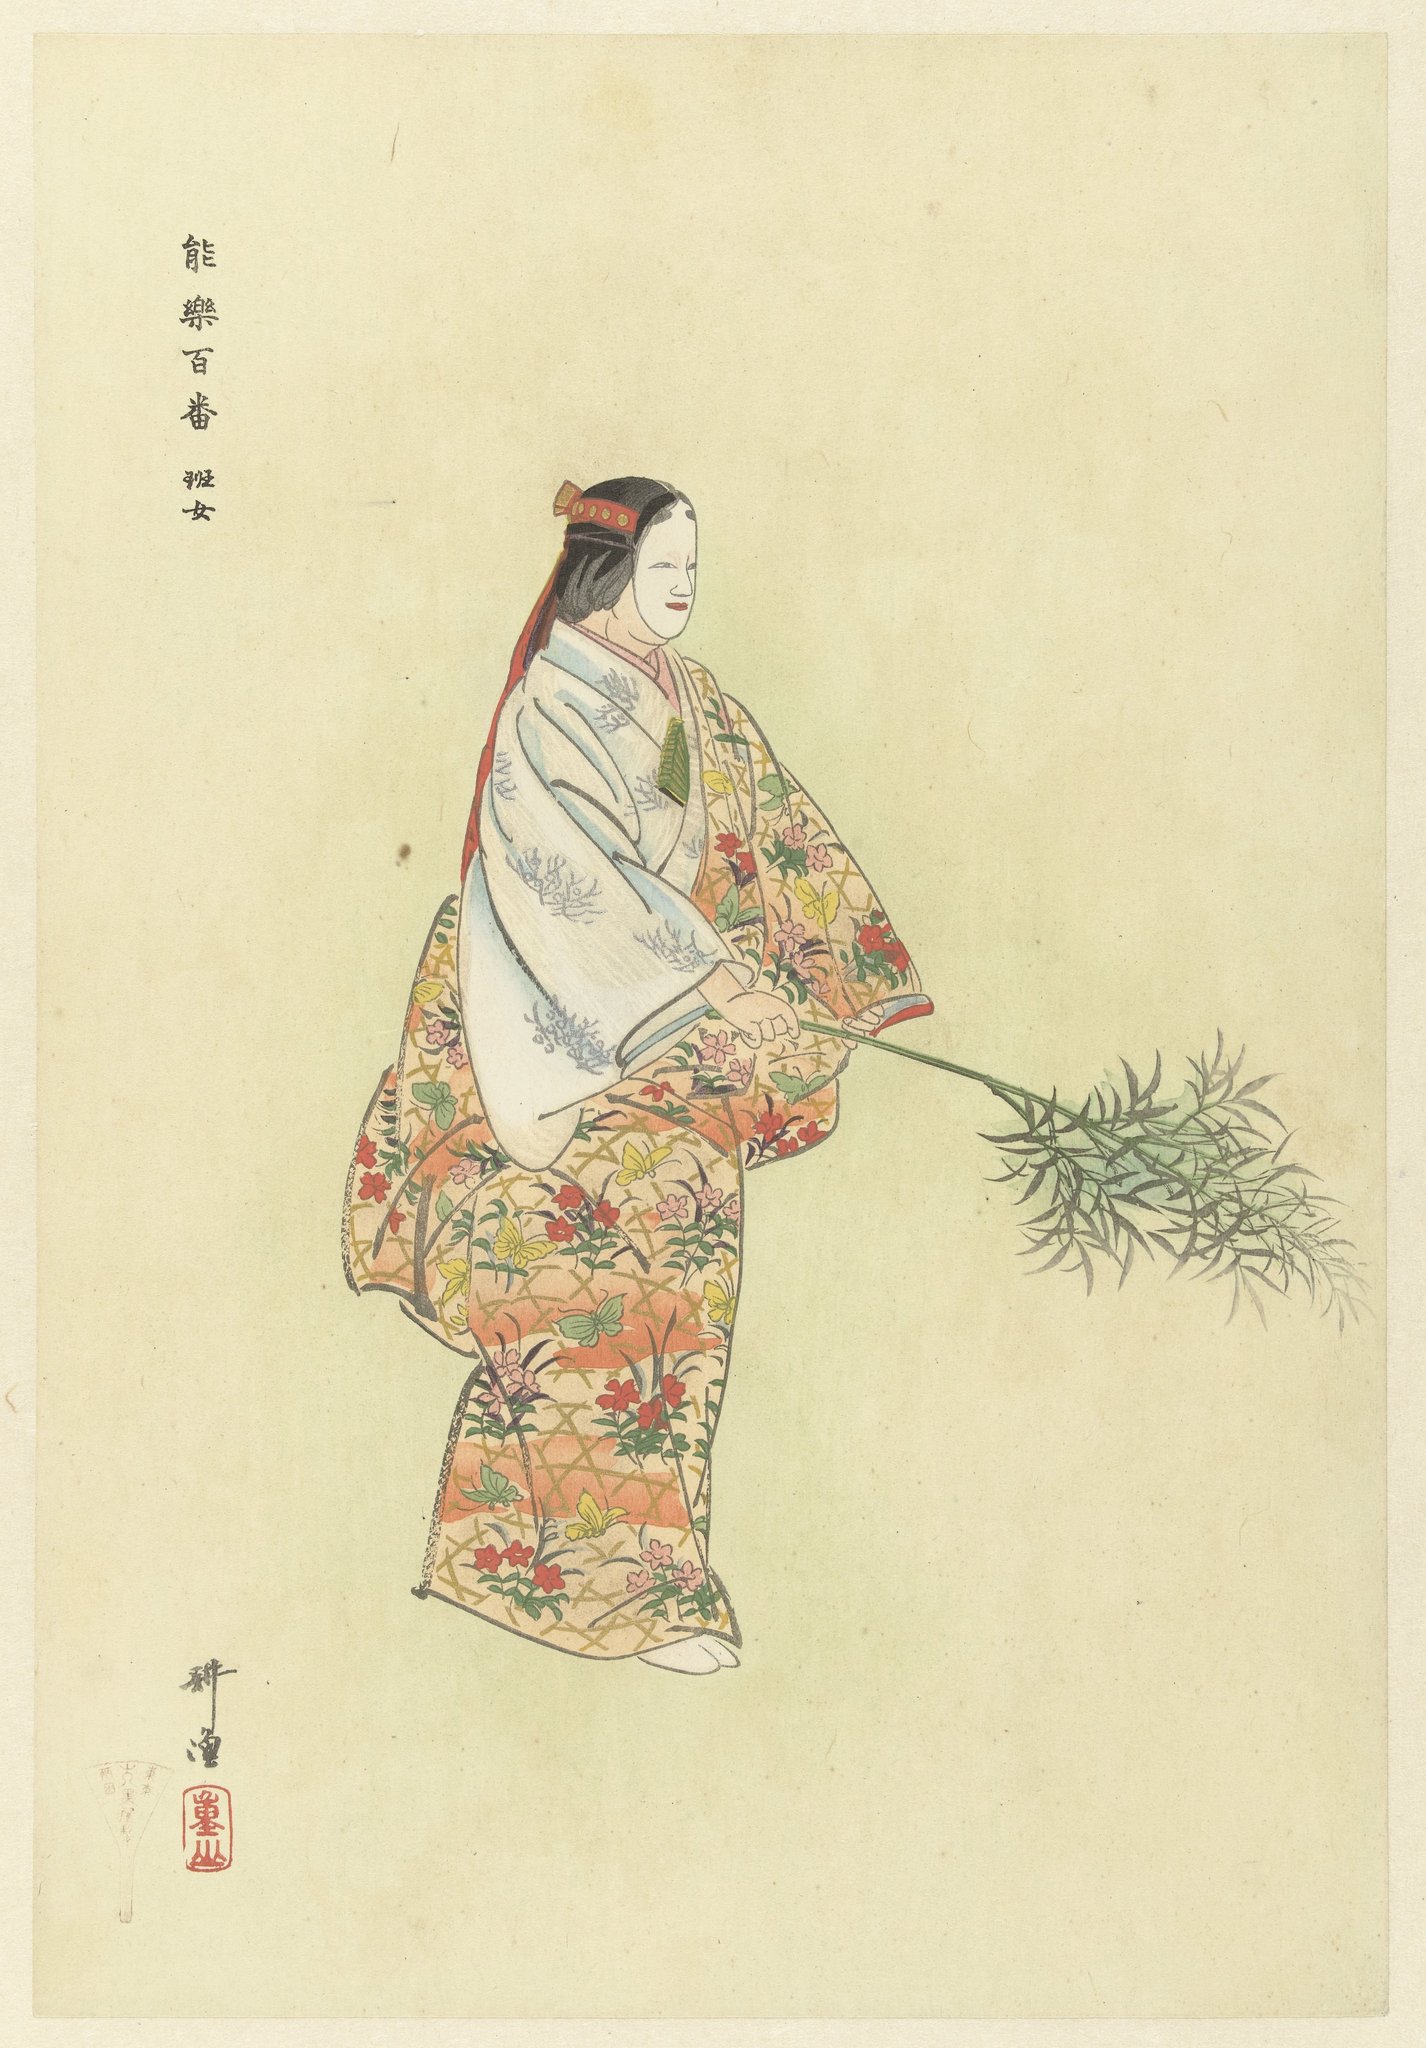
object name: print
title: Actor in the No Play Hanjo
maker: tsukioka kôgyo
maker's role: print maker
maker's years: 1869-1927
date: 1925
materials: paper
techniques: woodcut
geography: tokyo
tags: group of actors, troupe; actors on the stage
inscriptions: collector's mark: Lugt 2760, collector's mark: Lugt 2228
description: Hanjo, the woman depicted here, is a prostitute who found love with a passing traveller. She loses her mind and begins to roam aimlessly. Fortunately, she is – by chance – reunited with her lover. Accordingly, the themes addressed in this play are grief, loneliness, a pure heart, and the joy of reunion.